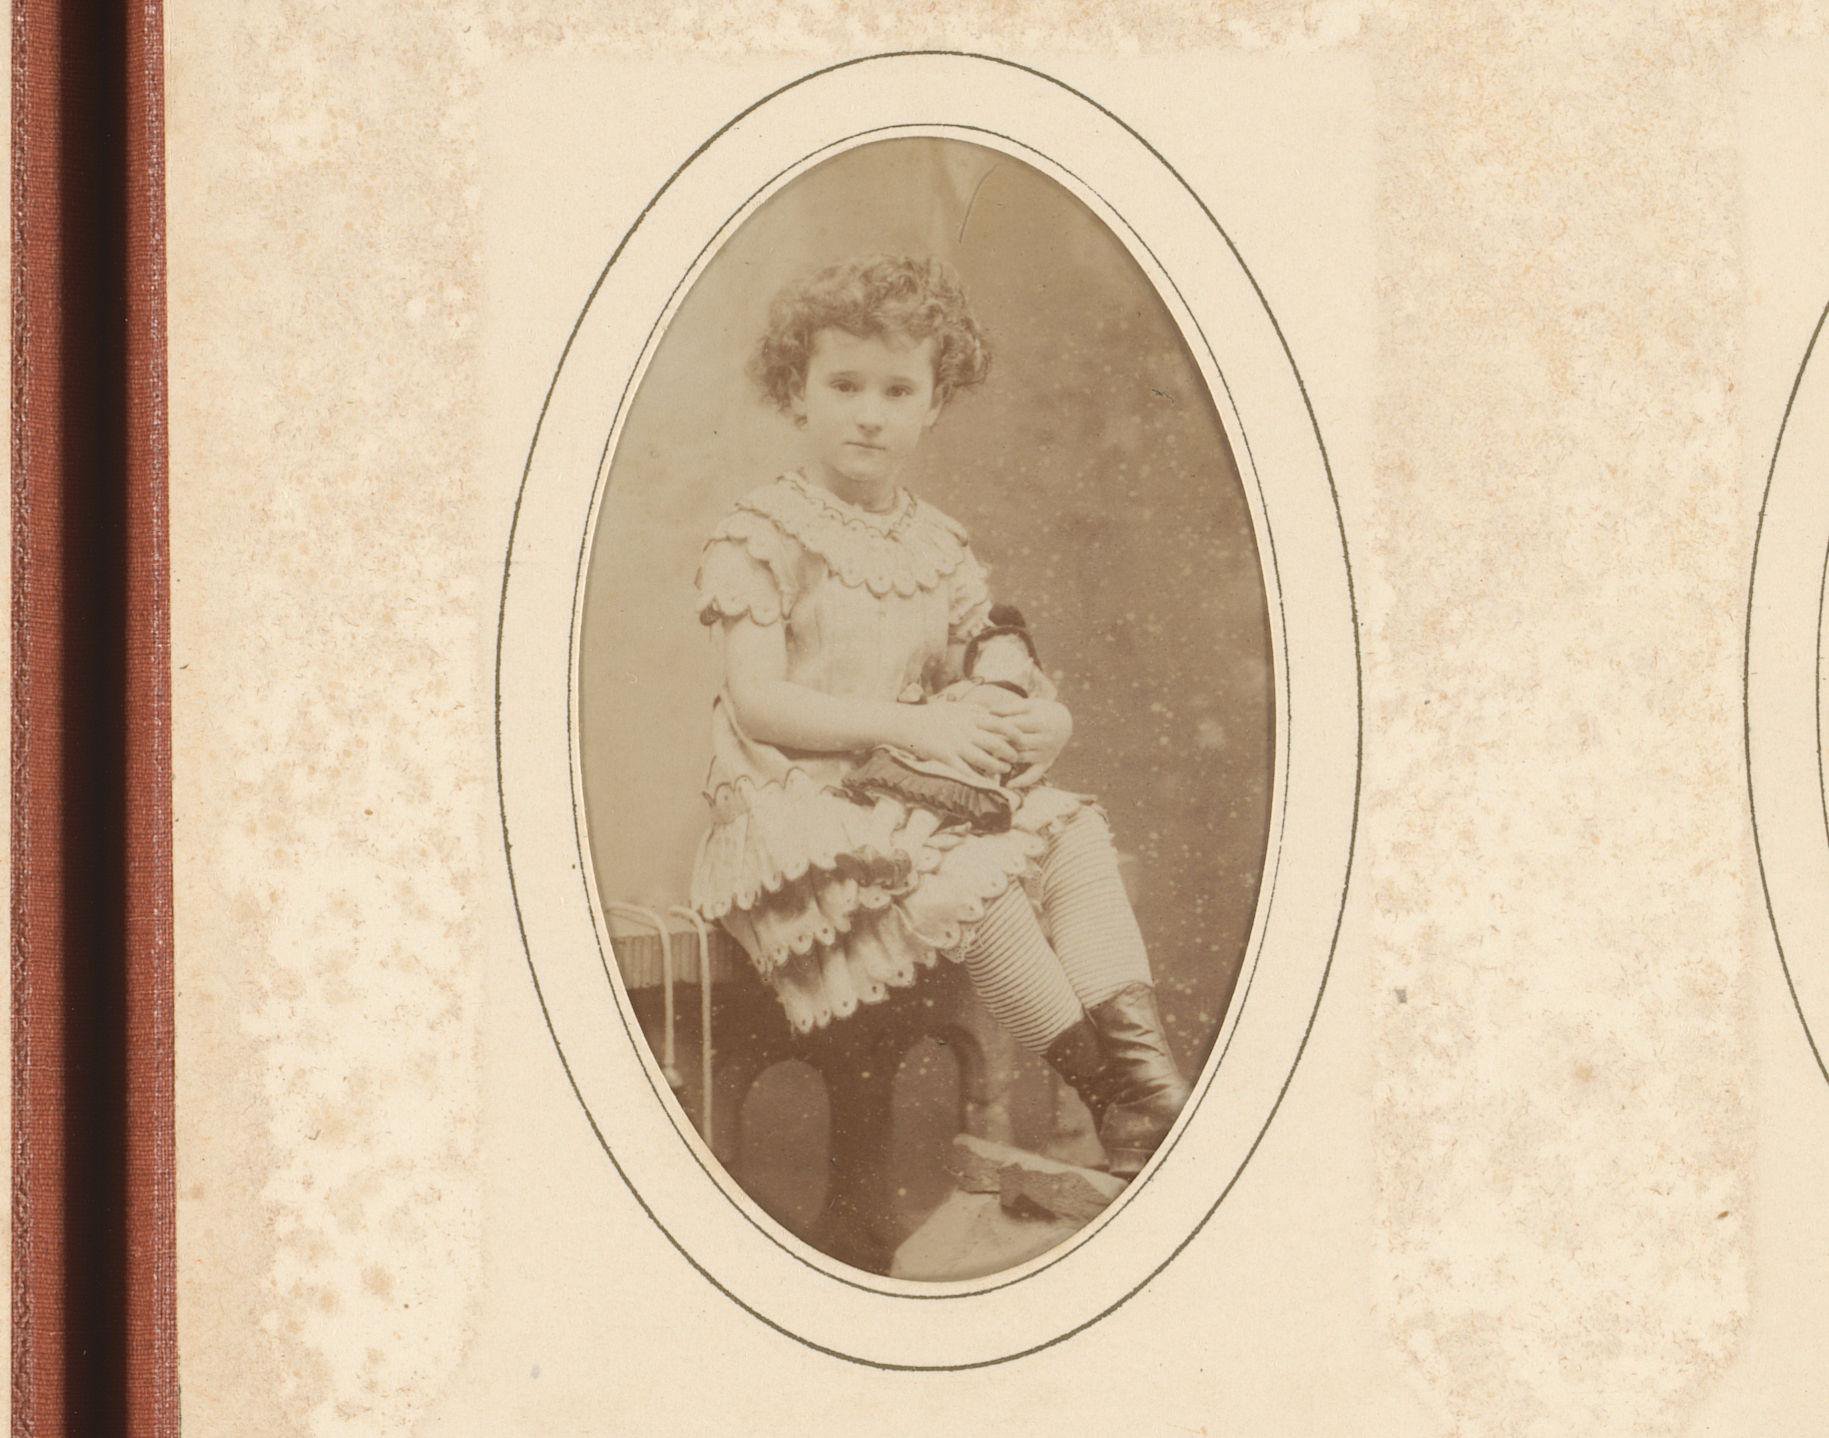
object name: carte de visite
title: Portret van een meisje met pop in de hand, zittend op een balustrade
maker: adolphe zimmermans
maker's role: fotograaf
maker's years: 1858-1922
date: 1884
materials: cardboard, photographic support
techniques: albumen print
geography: the hague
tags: historical persons - bb - woman, girl (child between toddler and youth), balustrade, (playing with) dolls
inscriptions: date: ‘25 12 84’, inscription: ‘Adolphe Zimmermans/ Photographe/ La Haye - Riemerstraat No 48.’